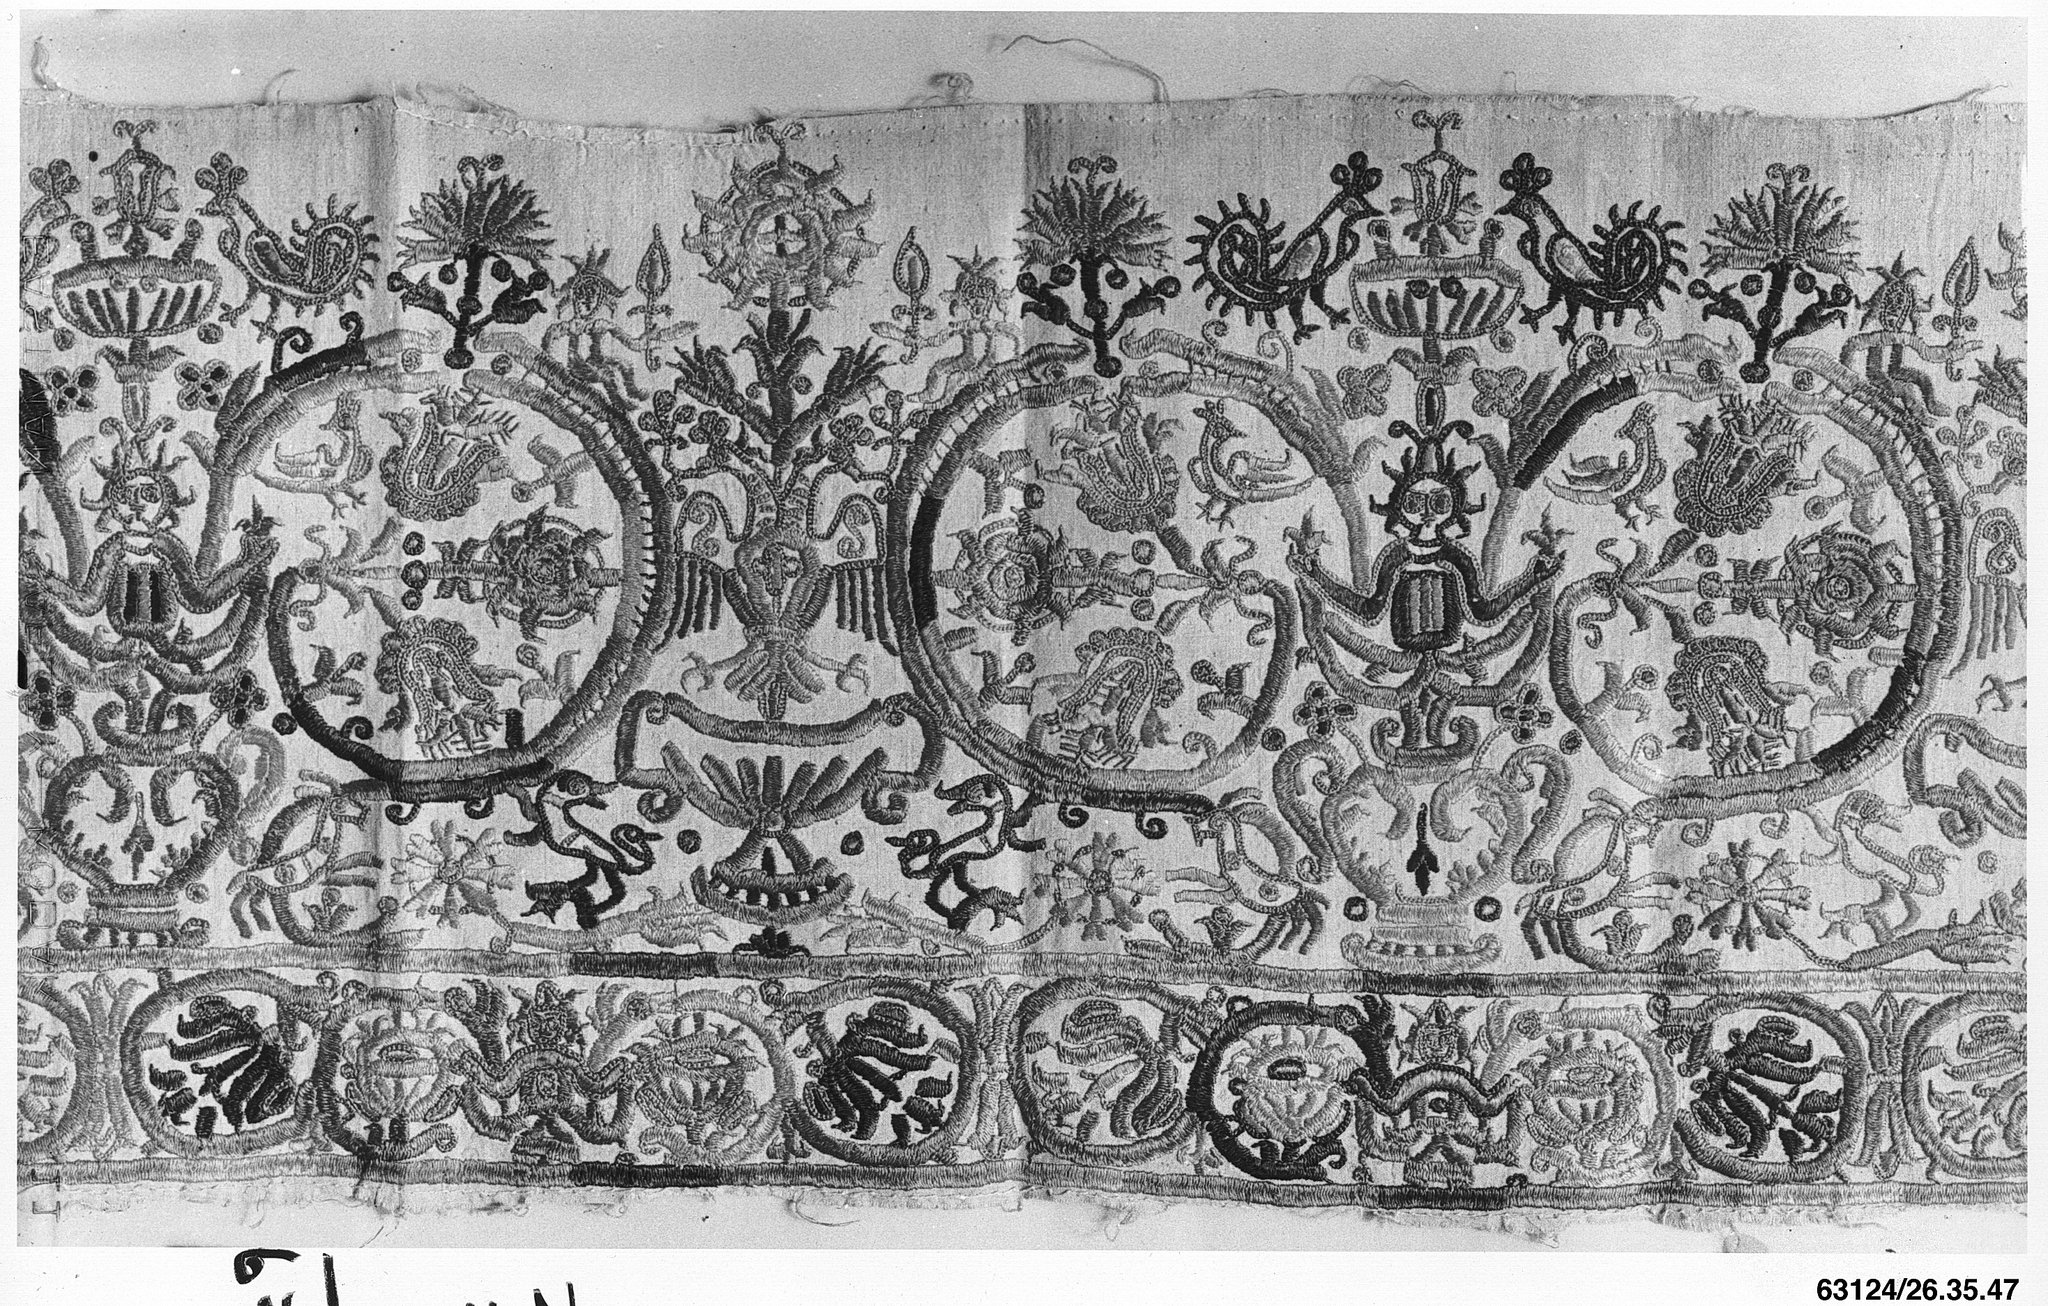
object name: border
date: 1701-1800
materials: linen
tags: birds,flowers